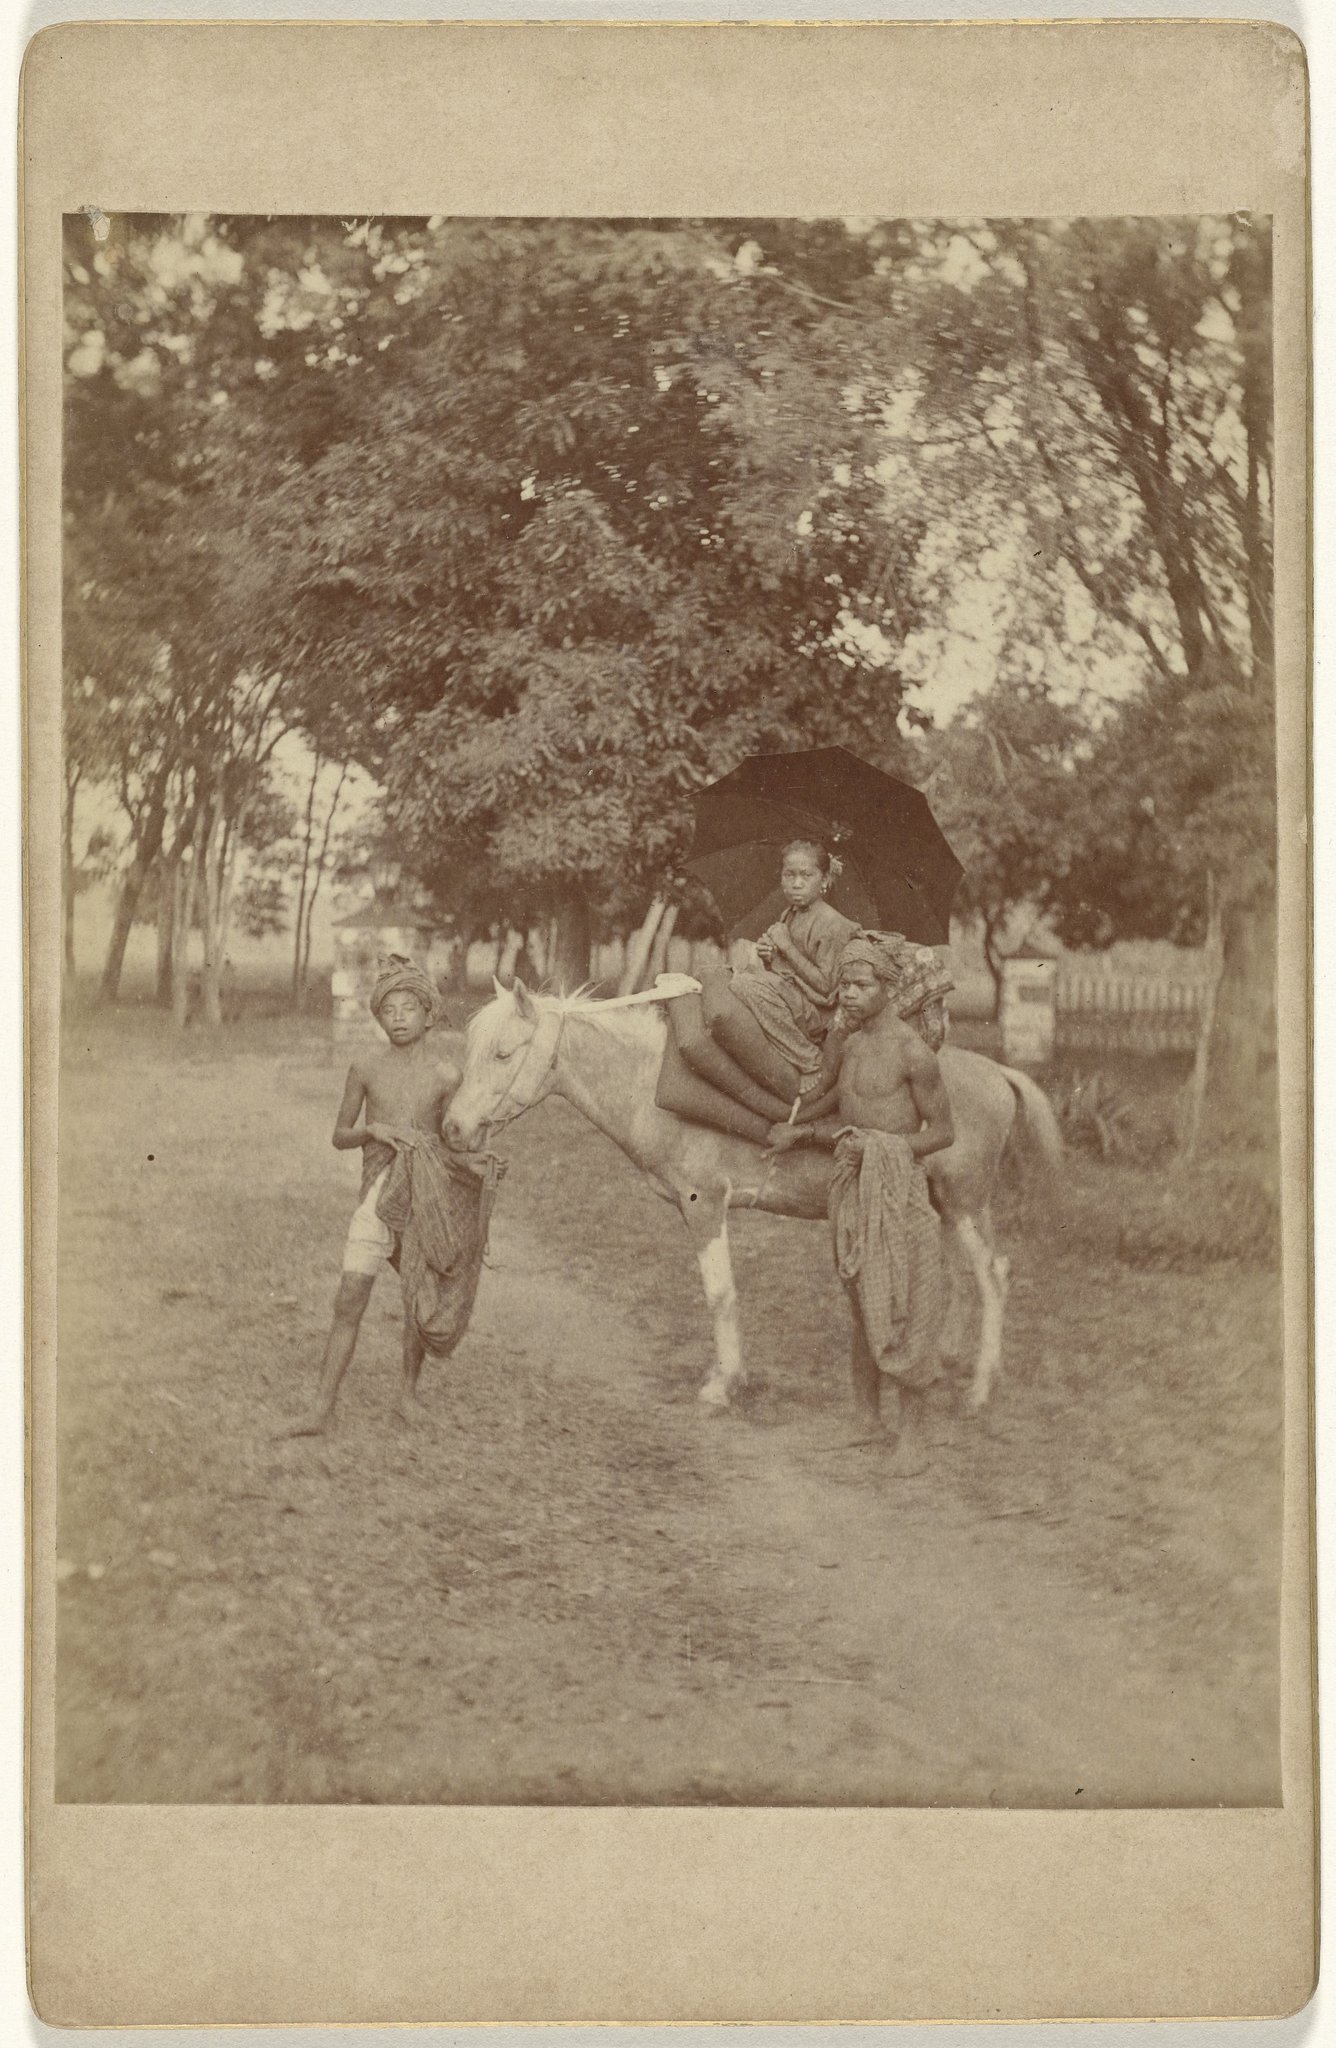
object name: cabinet photograph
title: Onbekende Boeginese prinses te paard met twee dienaren, Sulawesi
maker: Anonymous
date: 1870-1900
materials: cardboard, paper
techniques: albumen print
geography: sulawesi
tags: riding a horse, ass, or mule; rider, horseman, princess, manservant, footman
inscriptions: inscription: ‘Indische Prinzessin/ vom Stamme der Buginesen/ (Celebes) auf ihrem Pferde sitzend/ in Begleitung von 2 Dienern’